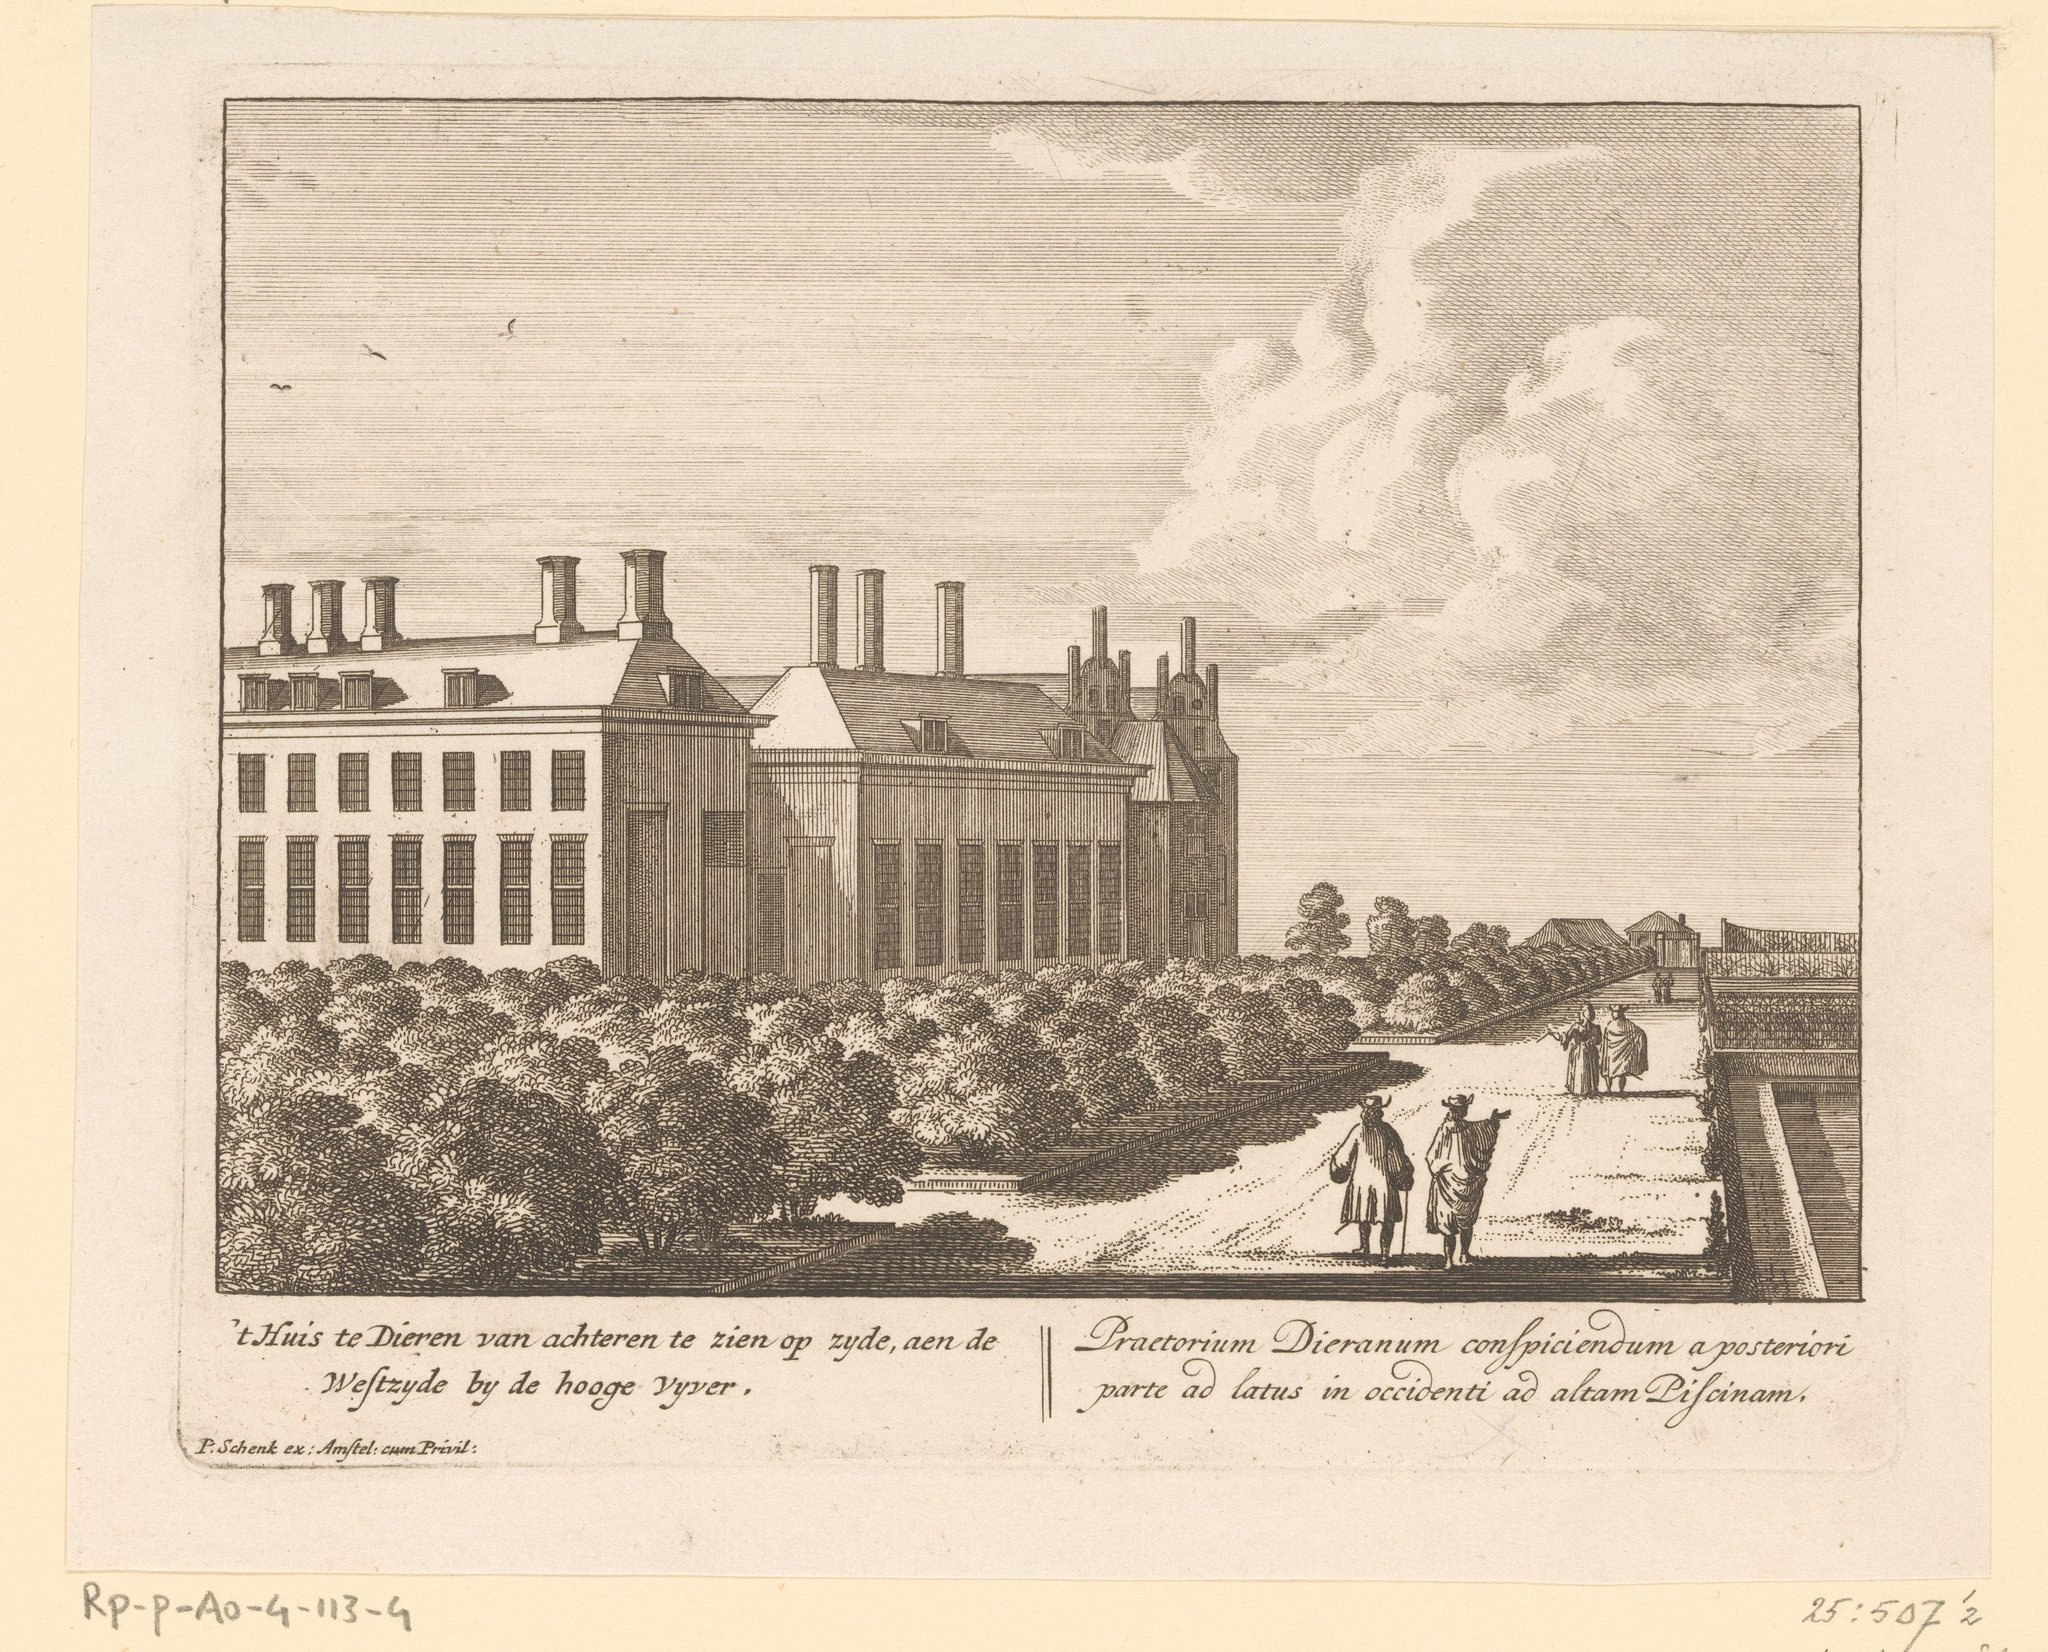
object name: print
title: 't Huis te Dieren van achteren te zien op zyde (...) / Praetorium Dieranum conspiciendum a posteriori parte (...)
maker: pieter schenk (i)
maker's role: print maker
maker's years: 1660-1711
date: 1700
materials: paper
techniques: engraving, etching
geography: amsterdam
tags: palace, french or architectonic garden; formal garden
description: Prent is uitgeven door Pieter Schenk (I) als onderdeel van de zestiendelige prentserie 'Praetorium Dieranum', ca. 1700. Later is de prent ook gebruikt in: Schenk, Pieter (I). Paradisus Oculorum: sive conspectus degantissimi centum (...). Jacobus Romanus, ca. 1700.